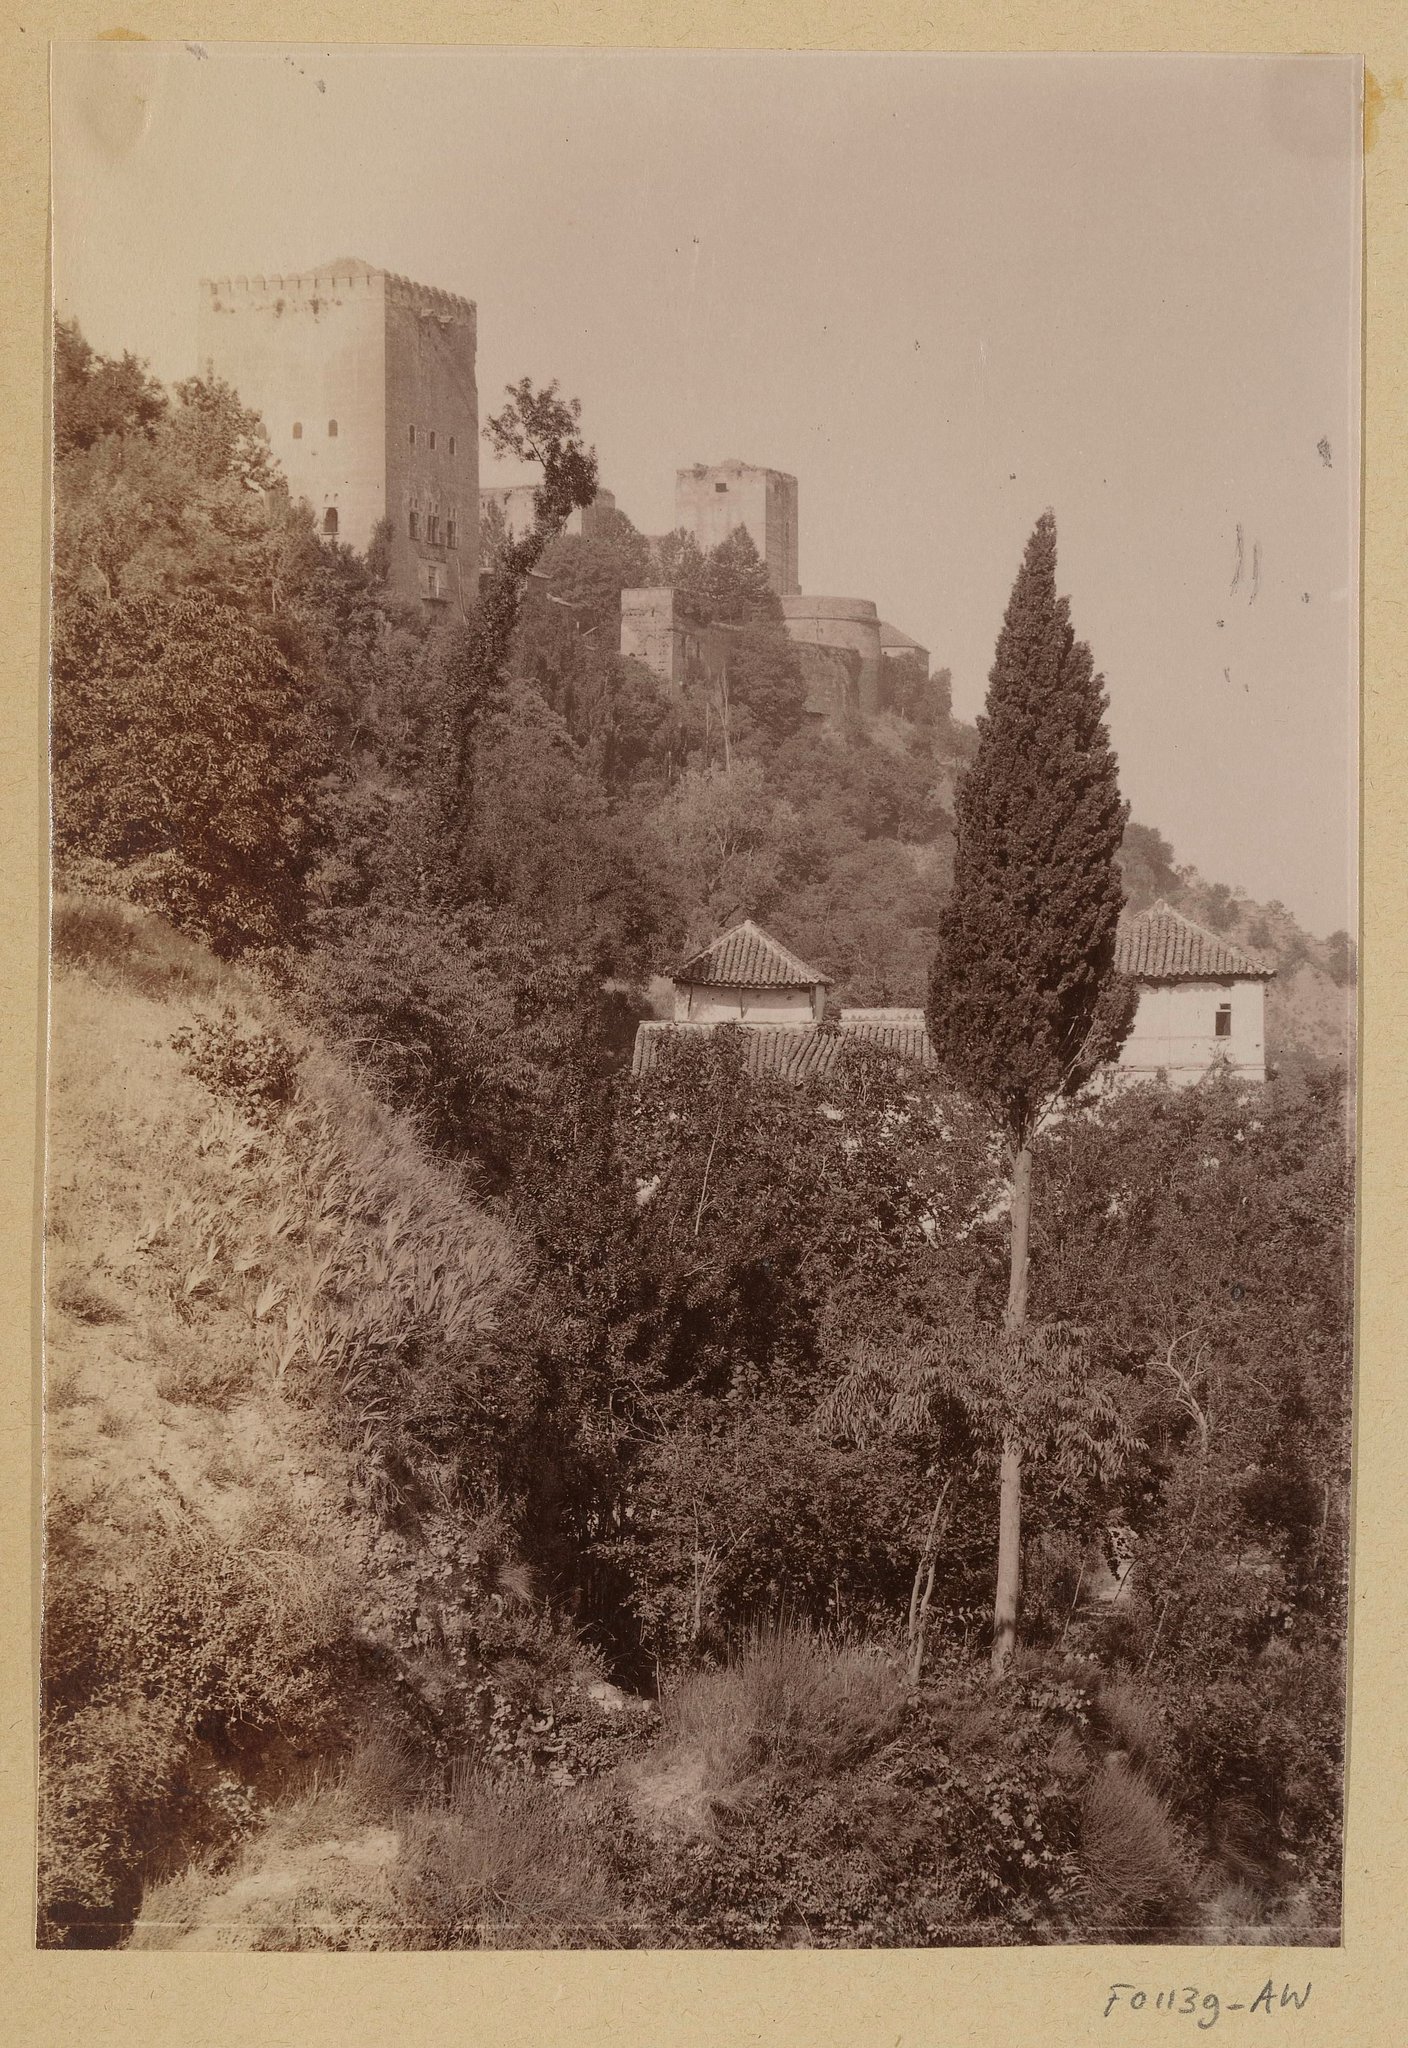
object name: photograph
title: Gezicht op het Alhambra in Granada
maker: Anonymous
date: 1851-1890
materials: paper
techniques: albumen print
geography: granada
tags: fortress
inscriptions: inscription: ‘Alhambra/ Granada’